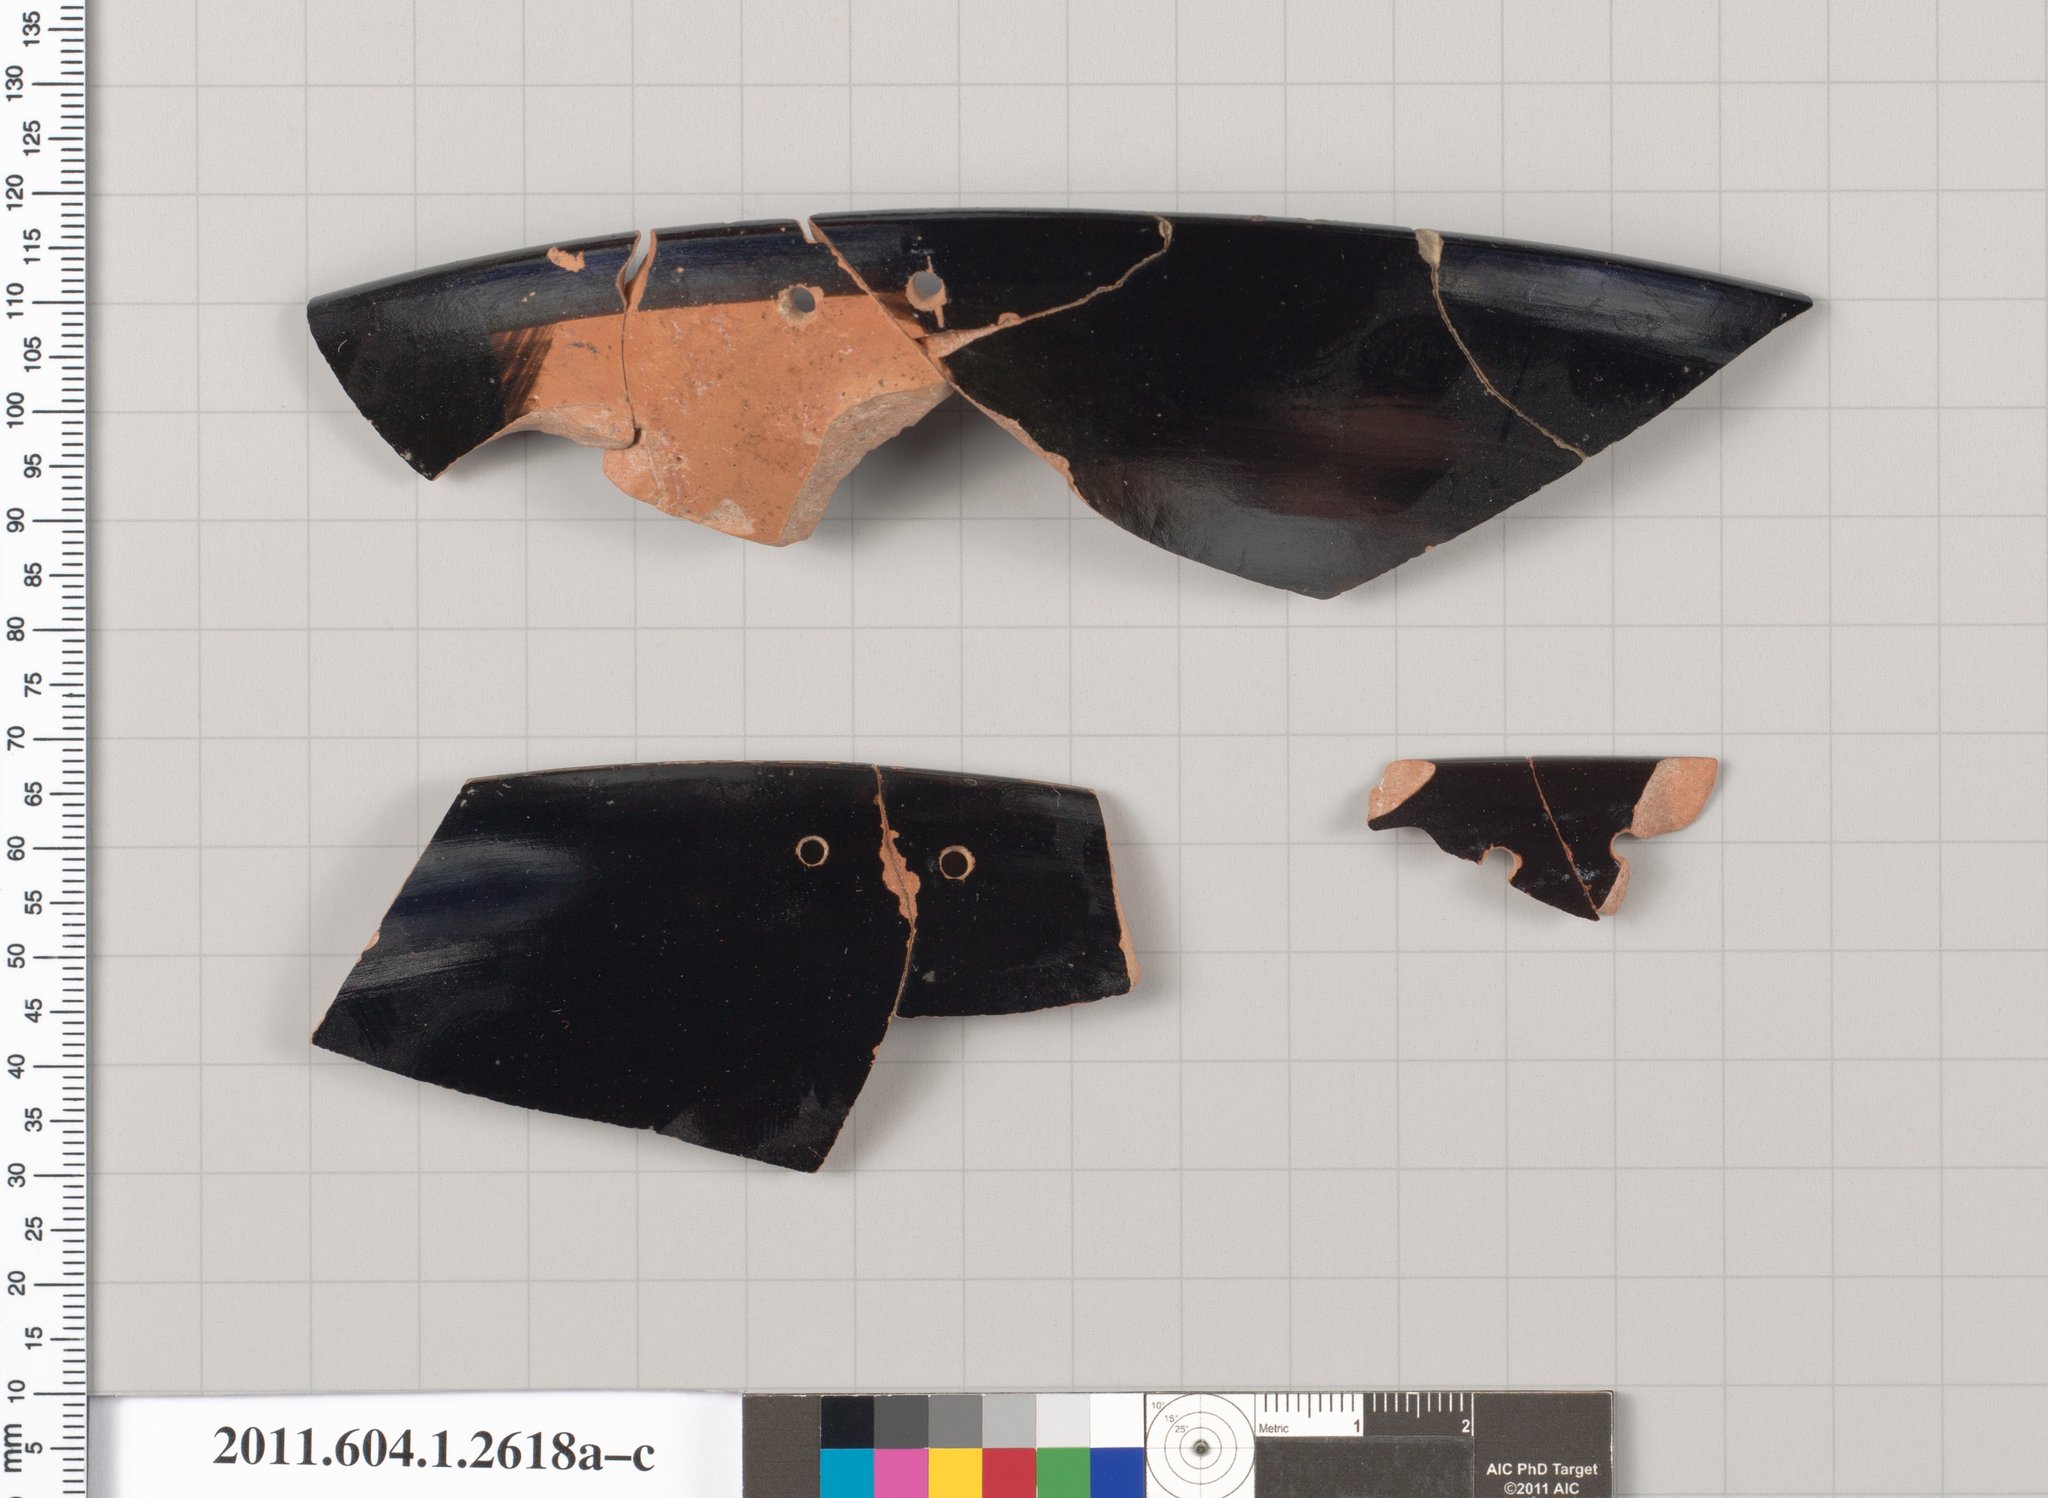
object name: kylix fragment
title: Terracotta rim fragments of a kylix (drinking cup)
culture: greek, attic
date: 500-401 BCE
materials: terracotta